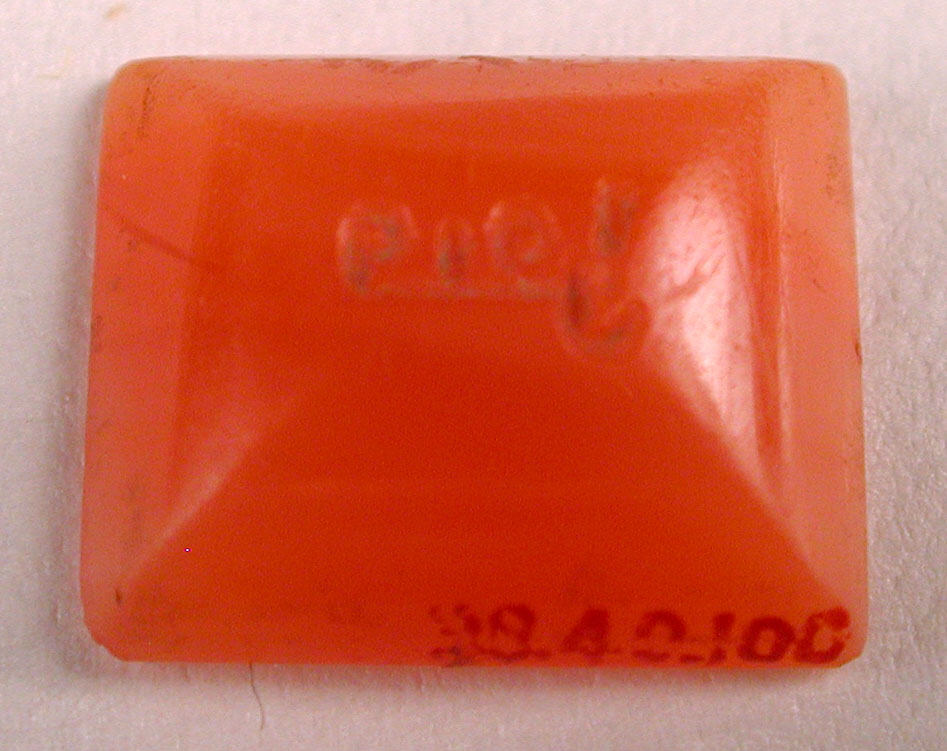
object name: seal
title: Seal Stone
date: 901-1100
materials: gemstone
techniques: incising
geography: iran